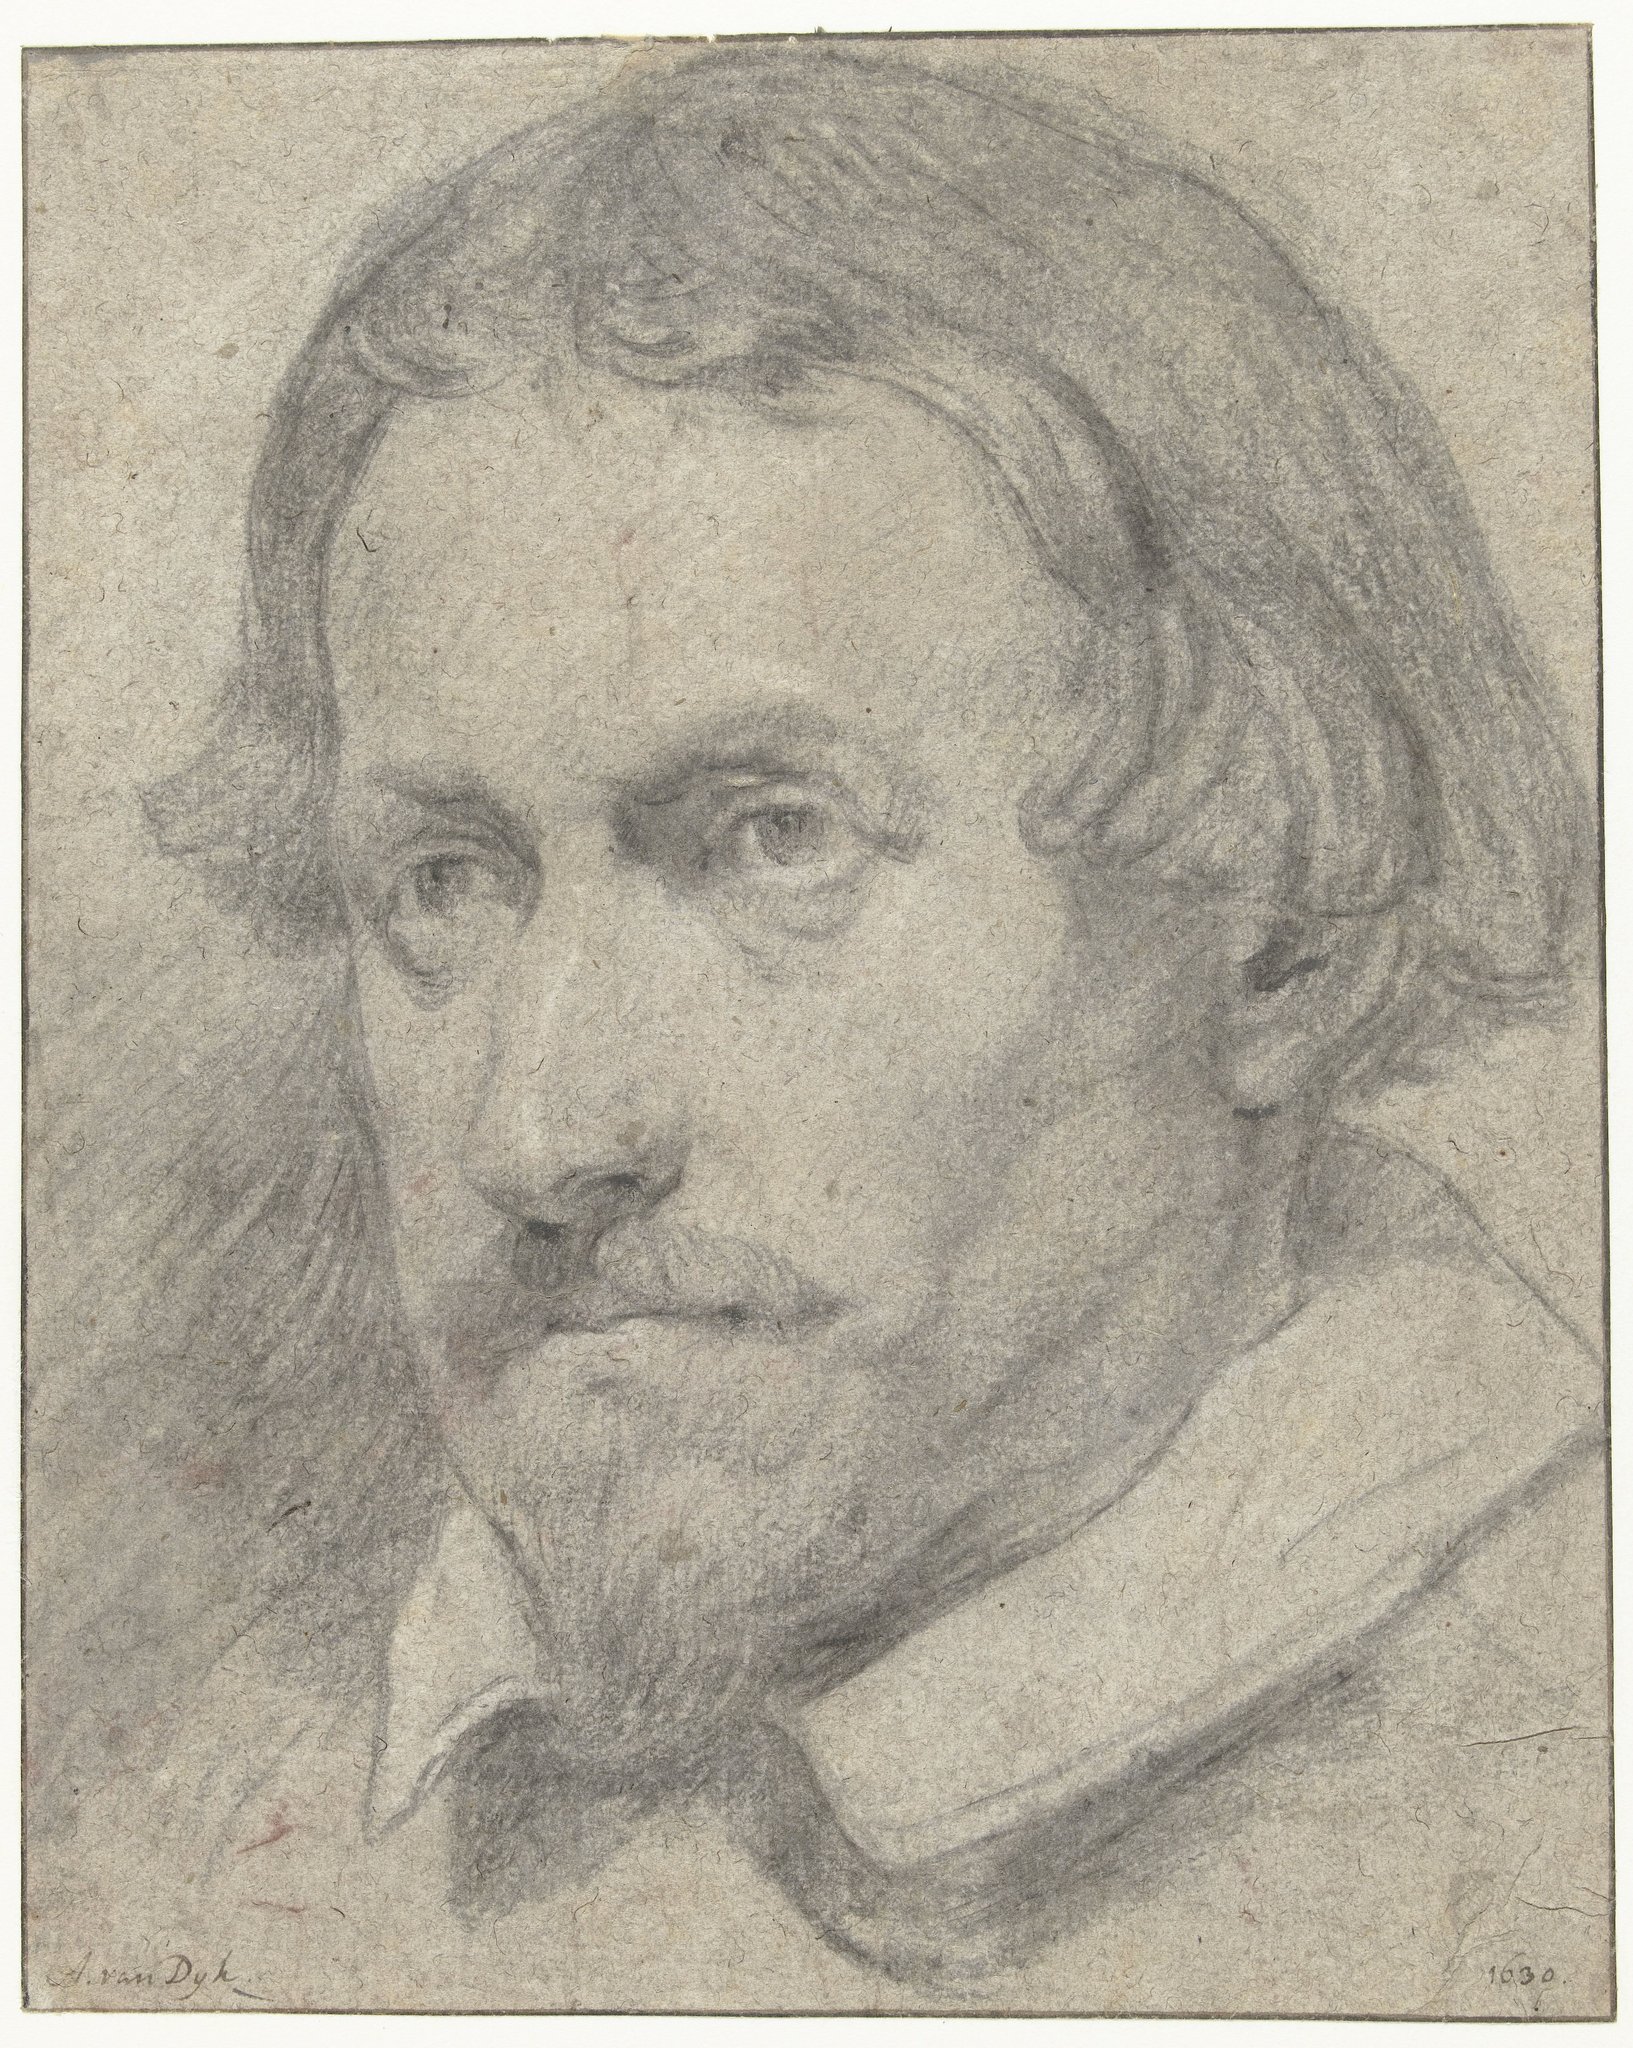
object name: drawing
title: Manskop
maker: anthony van dyck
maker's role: draughtsman, painter, print maker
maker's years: 1599-1641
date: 1610-1641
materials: paper, chalk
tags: anonymous historical person portrayed alone